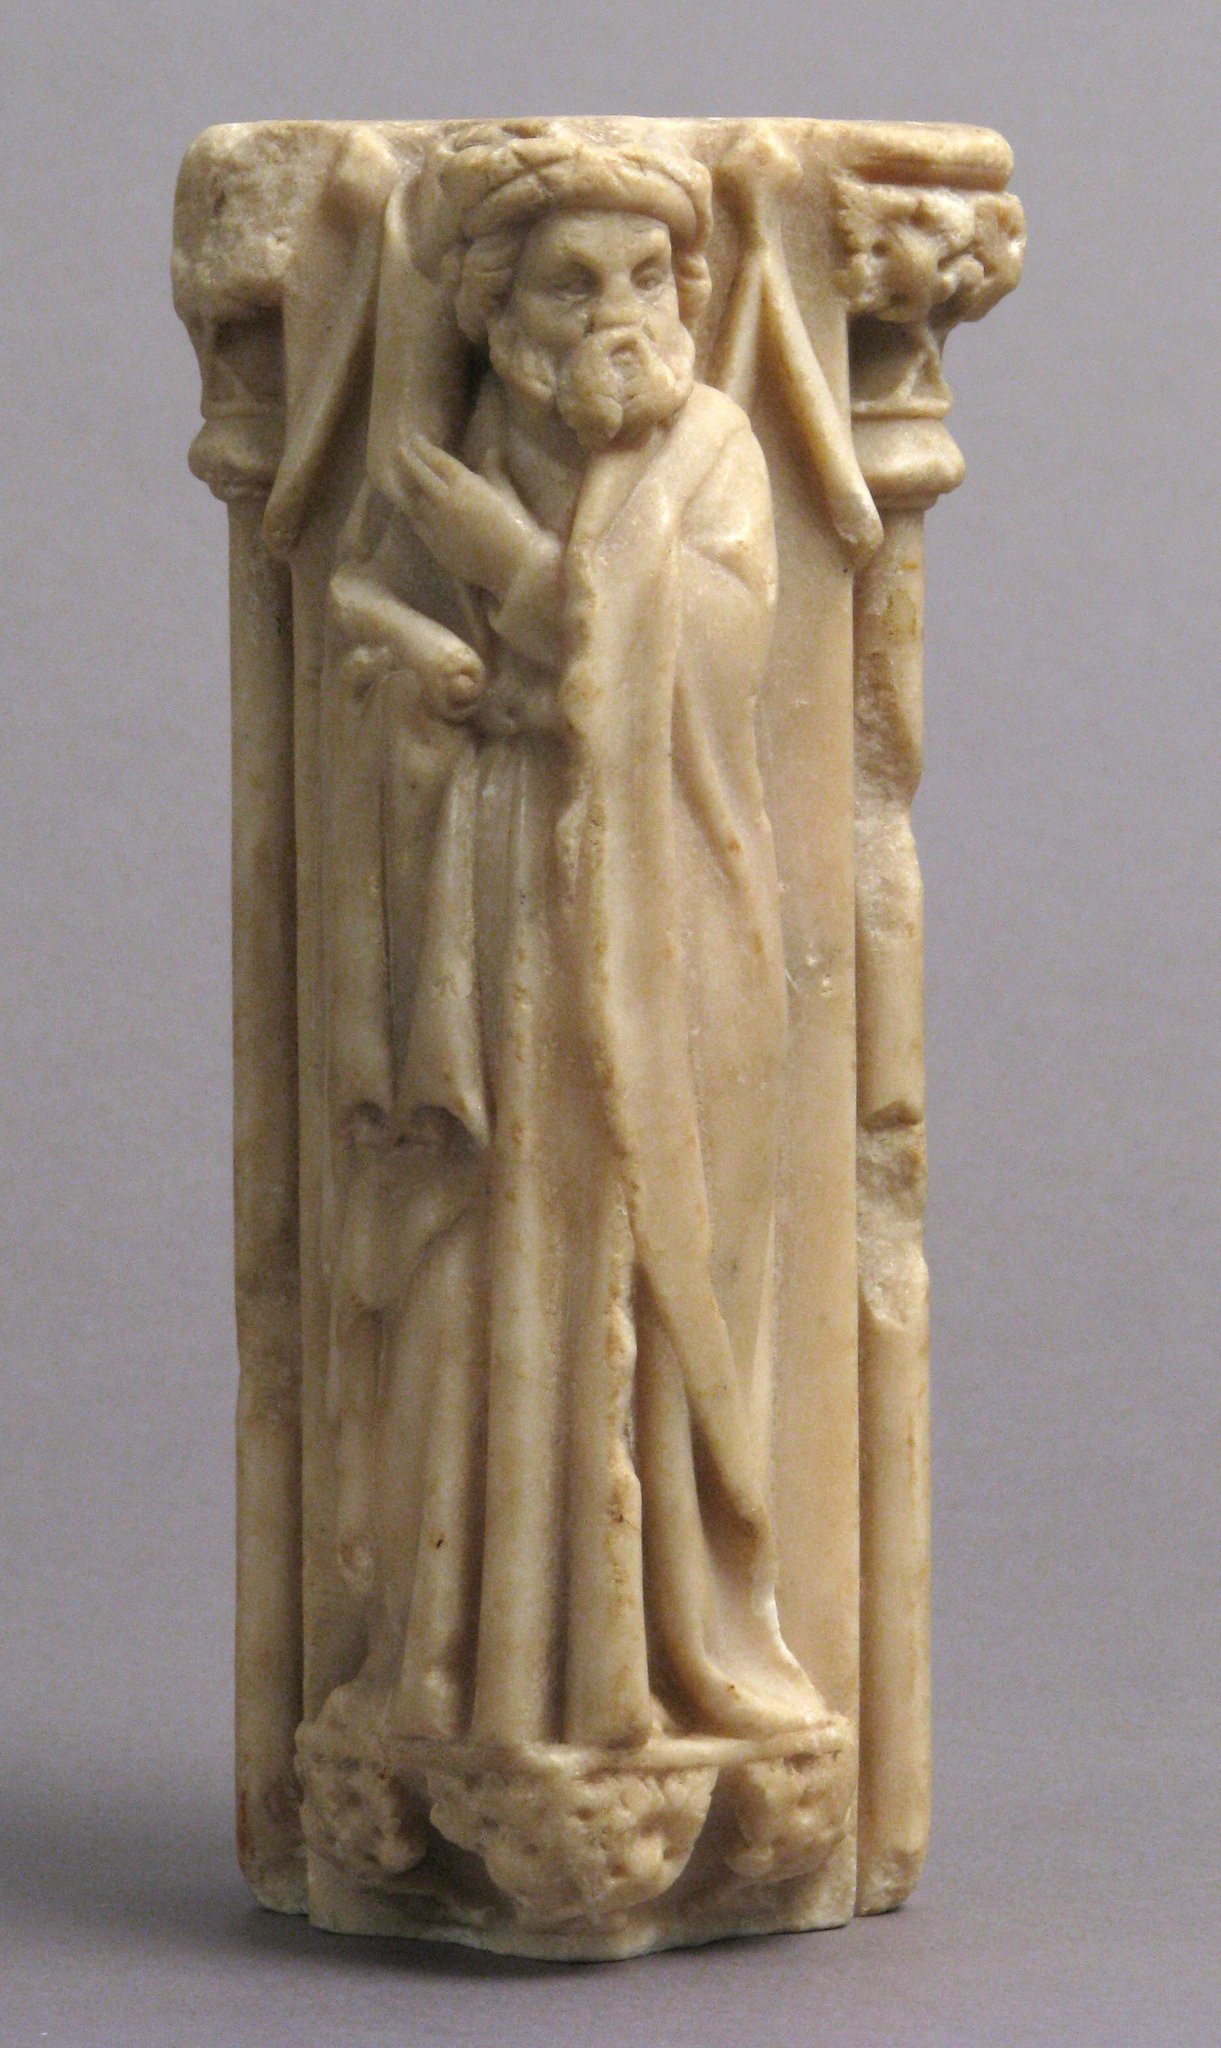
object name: relief fragment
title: Architectural Fragment from a Retable, Tabernacle, or Tomb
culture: french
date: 1400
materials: marble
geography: france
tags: tombs